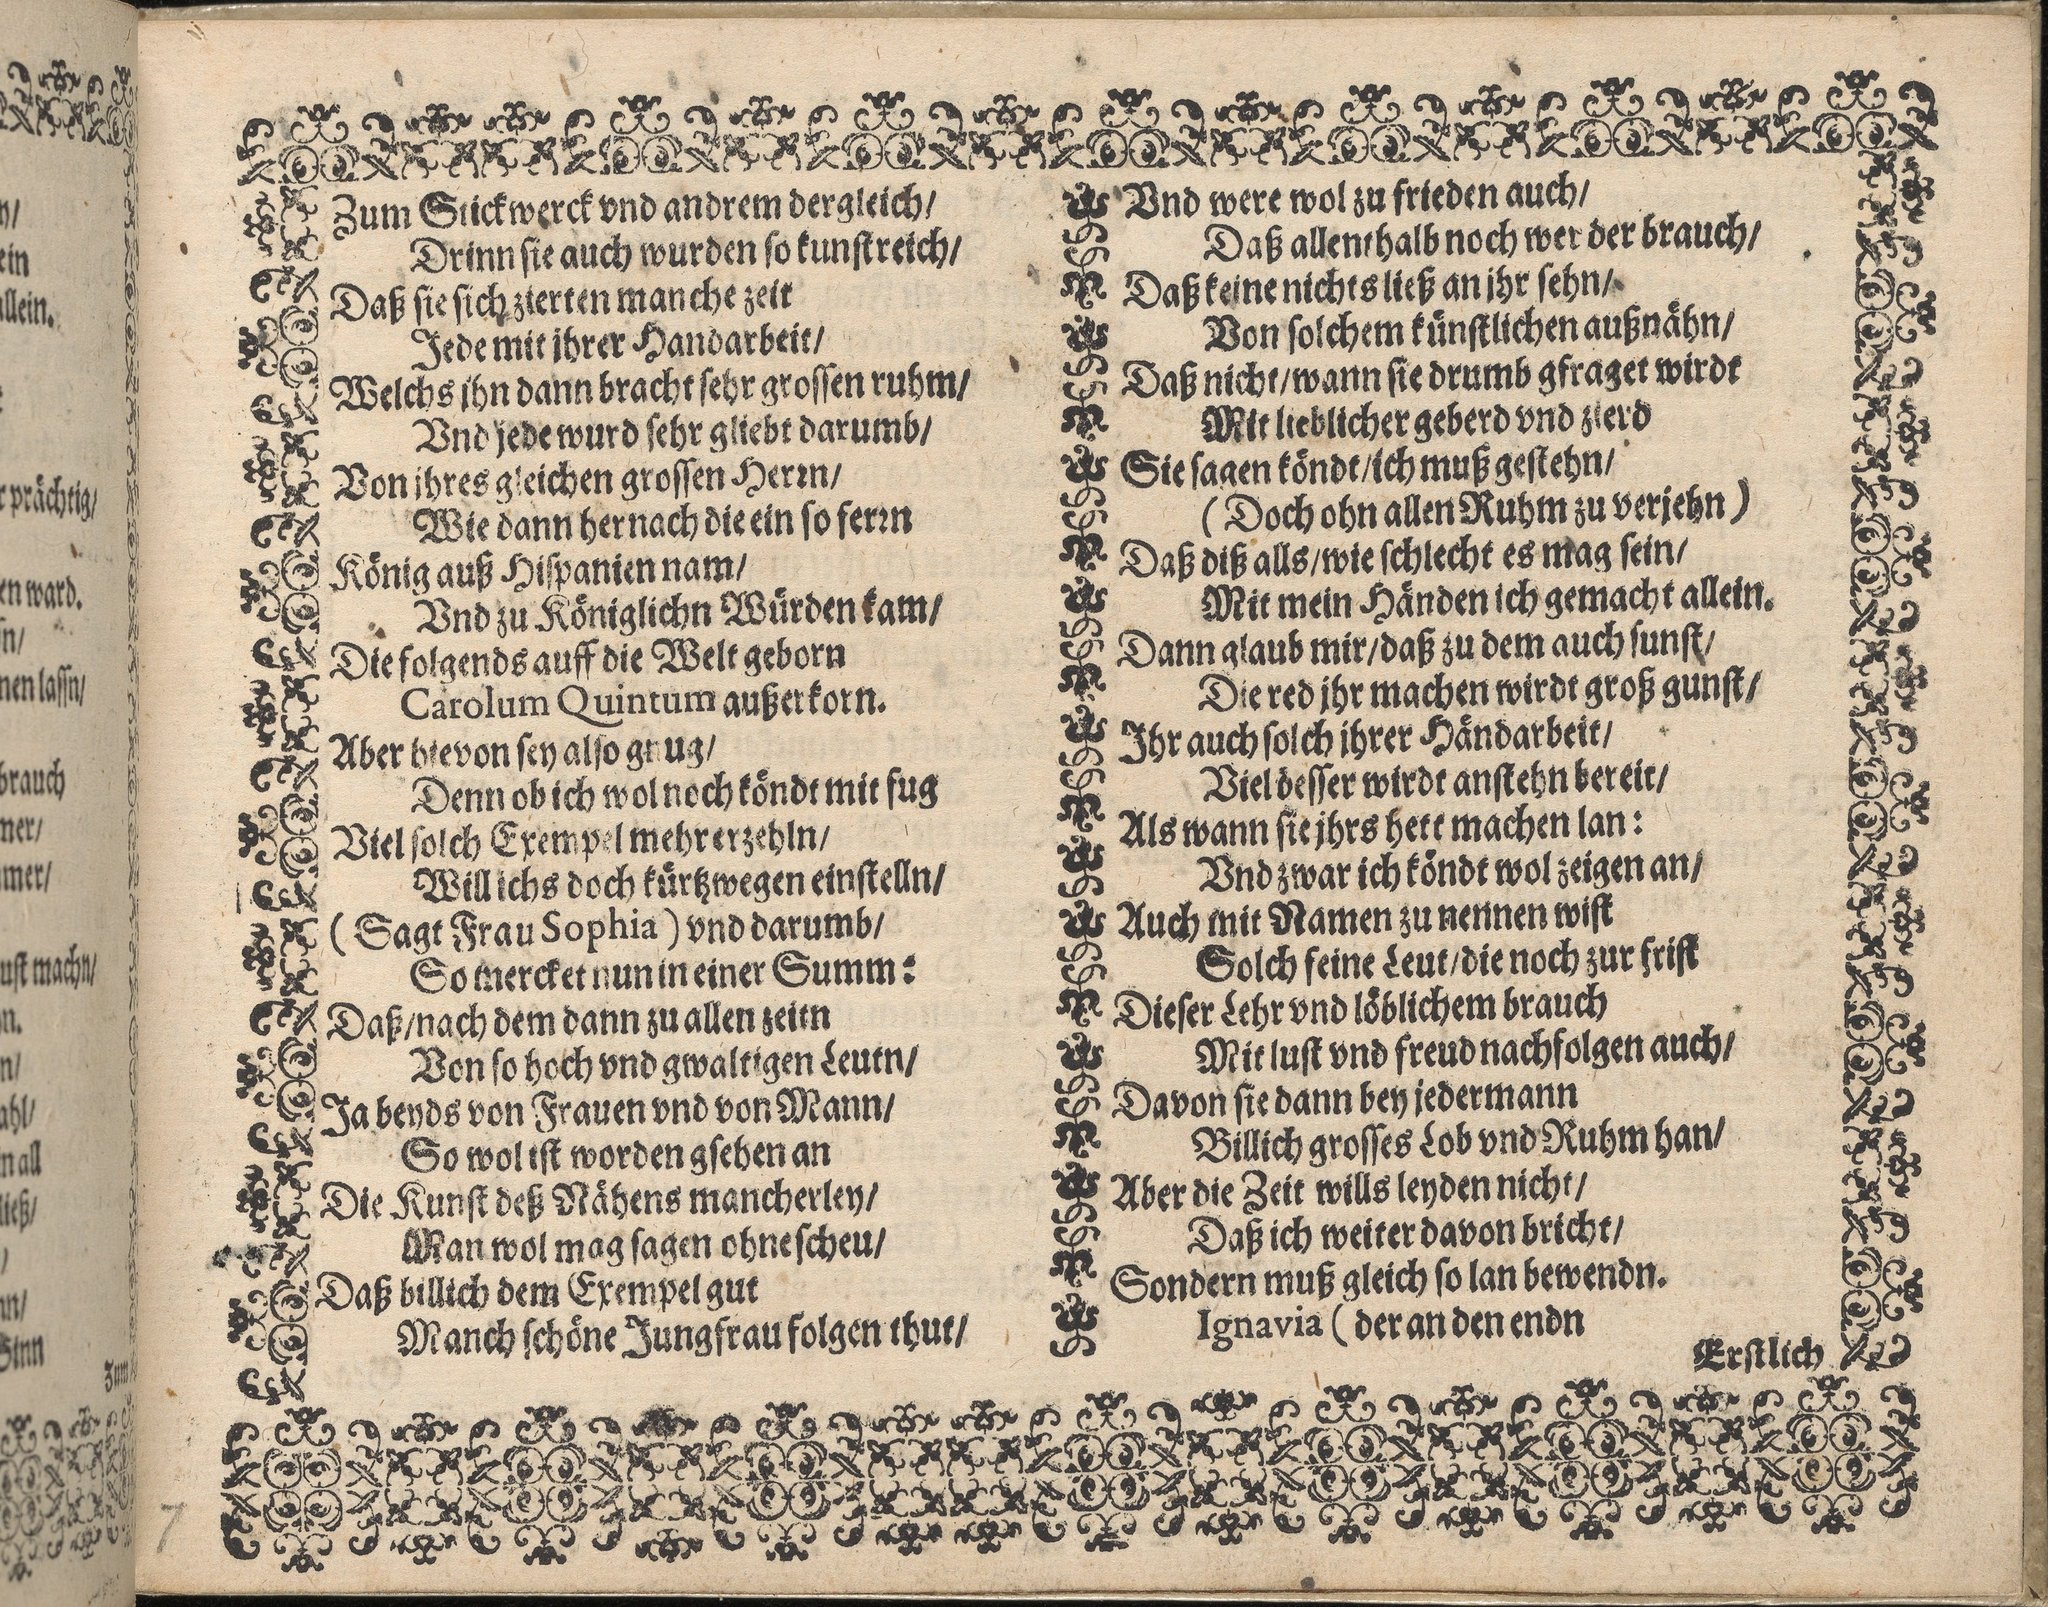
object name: book print ornament architecture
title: Newes Modelbuch in Kupffer (Page 7v)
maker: johann sibmacher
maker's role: artist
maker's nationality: german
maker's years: 1590-1611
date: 1604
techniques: woodcut